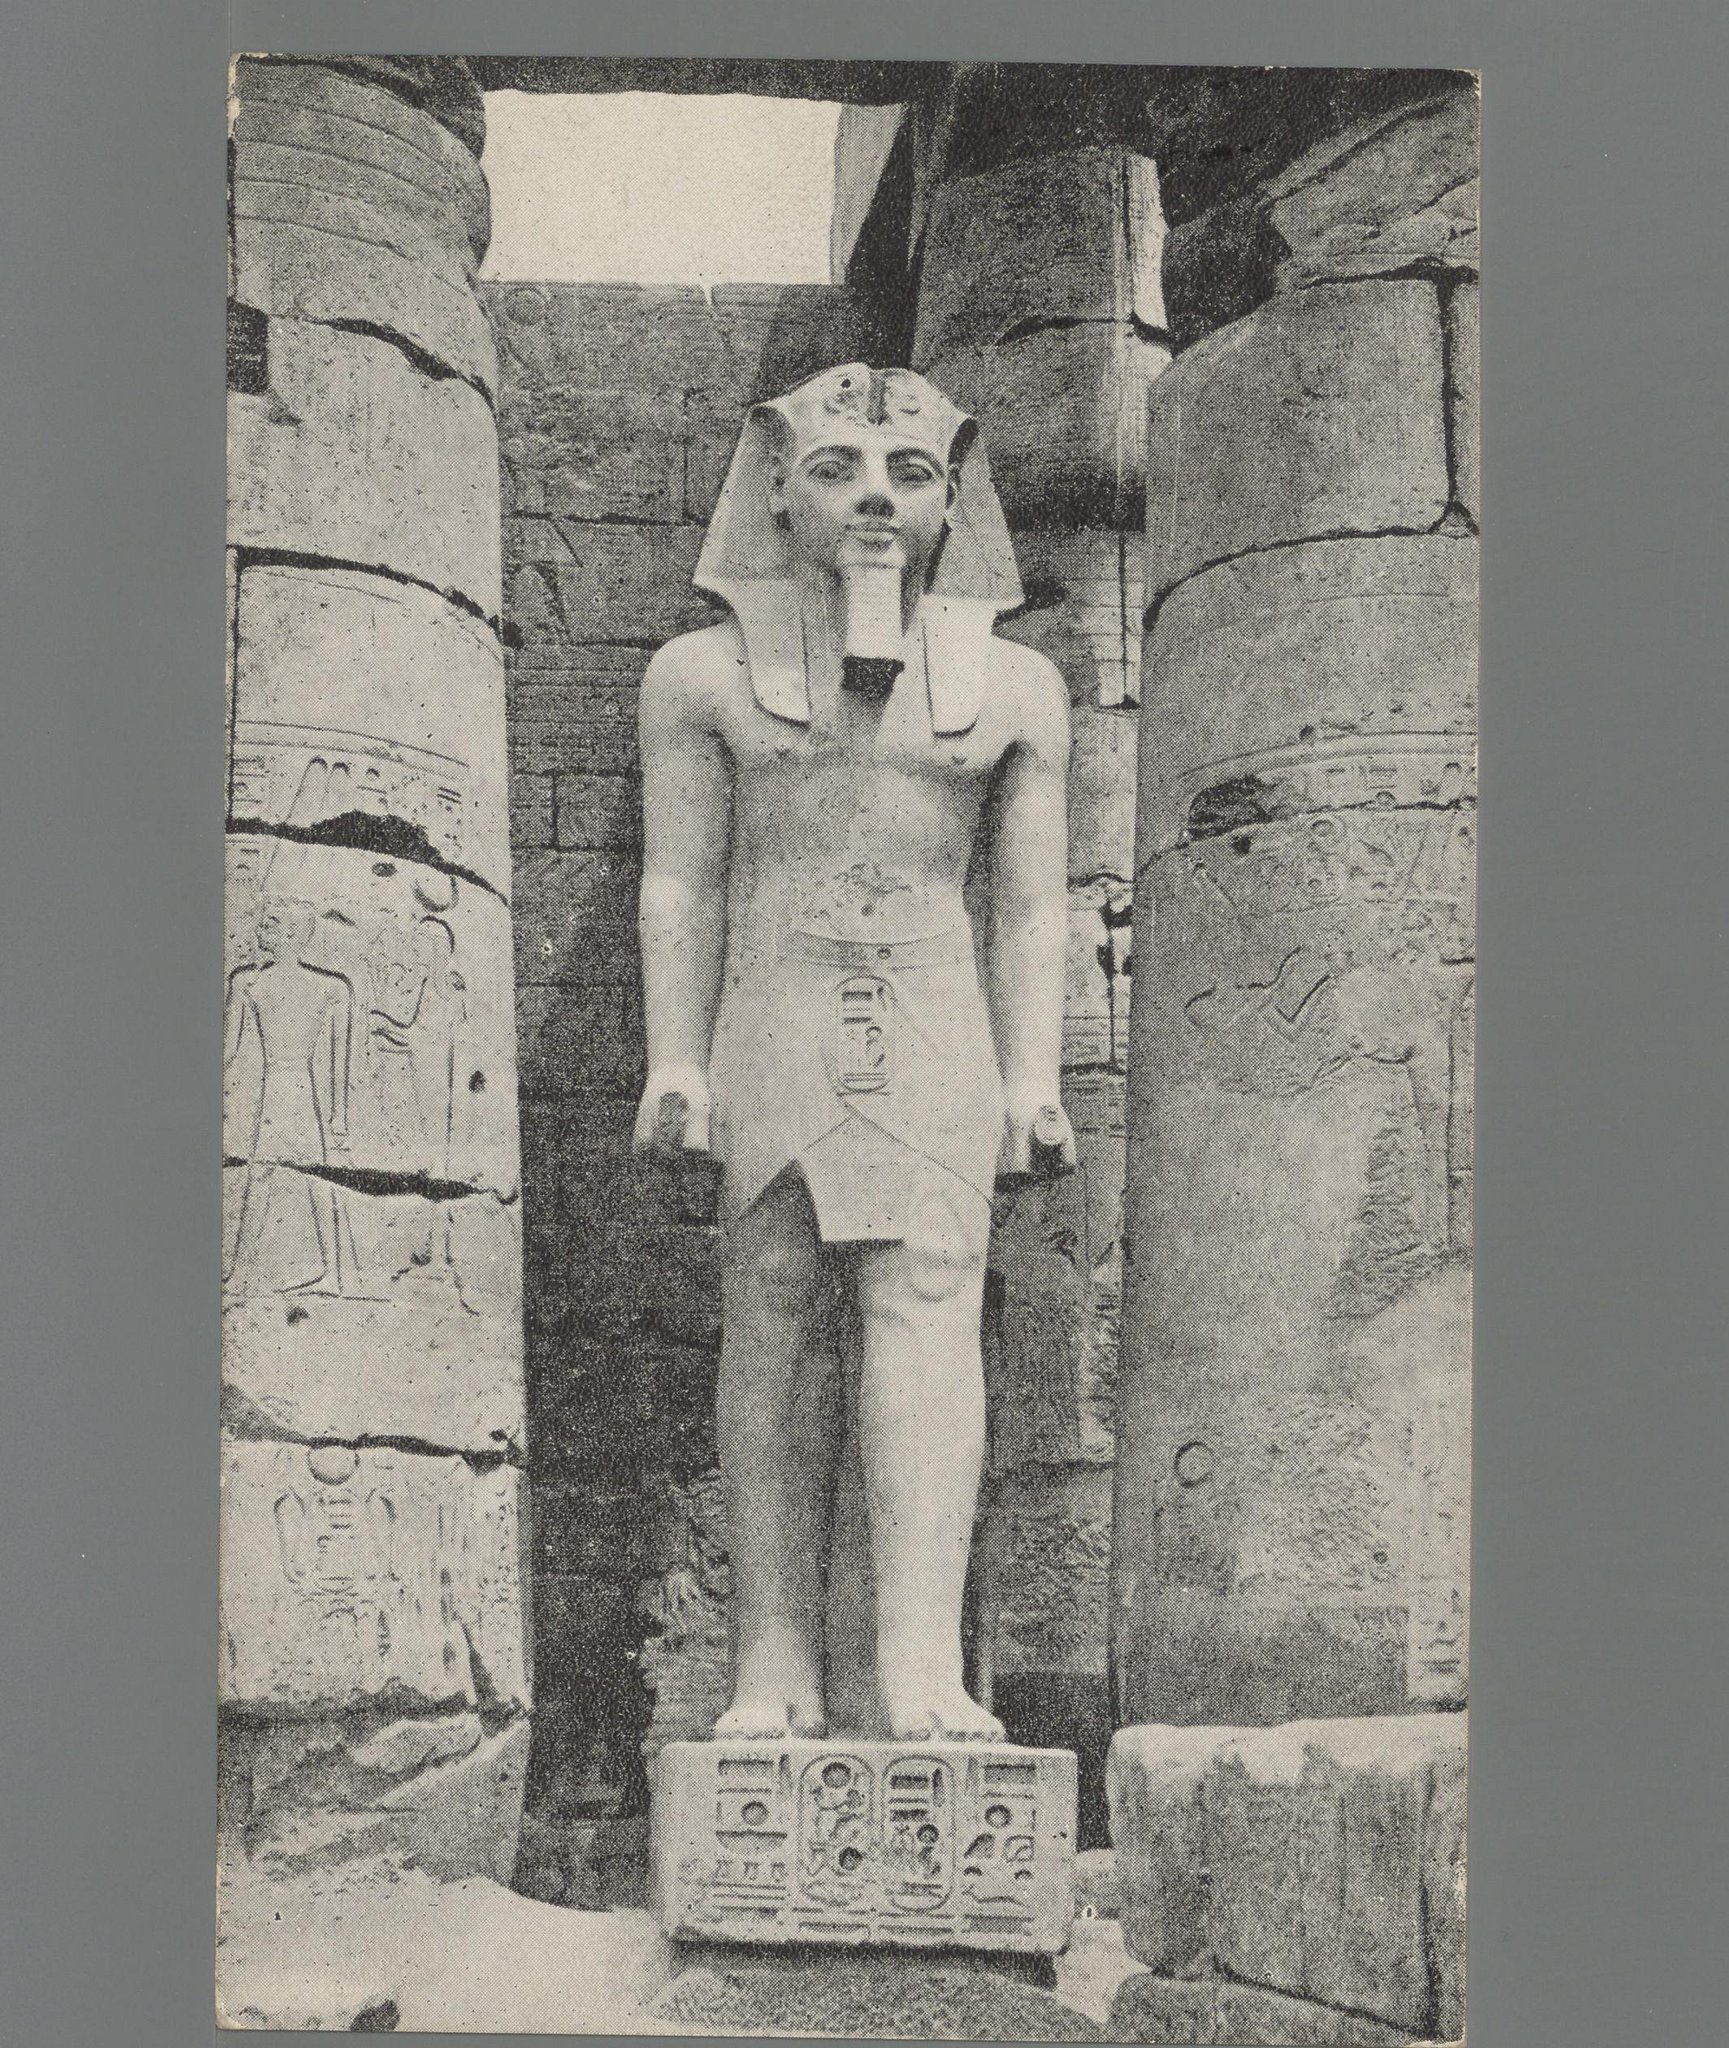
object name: ansichtkaart, prentbriefkaart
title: Luxor. Statue of Rameses II, 19th dynasty, 1300 B.C.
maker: Anonymous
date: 1907-1925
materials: cardboard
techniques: writing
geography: luxor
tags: temple, shrine ~ egyptian religion, statues, paintings, etc. ~ objects of worship (egyptian religion)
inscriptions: postage stamp